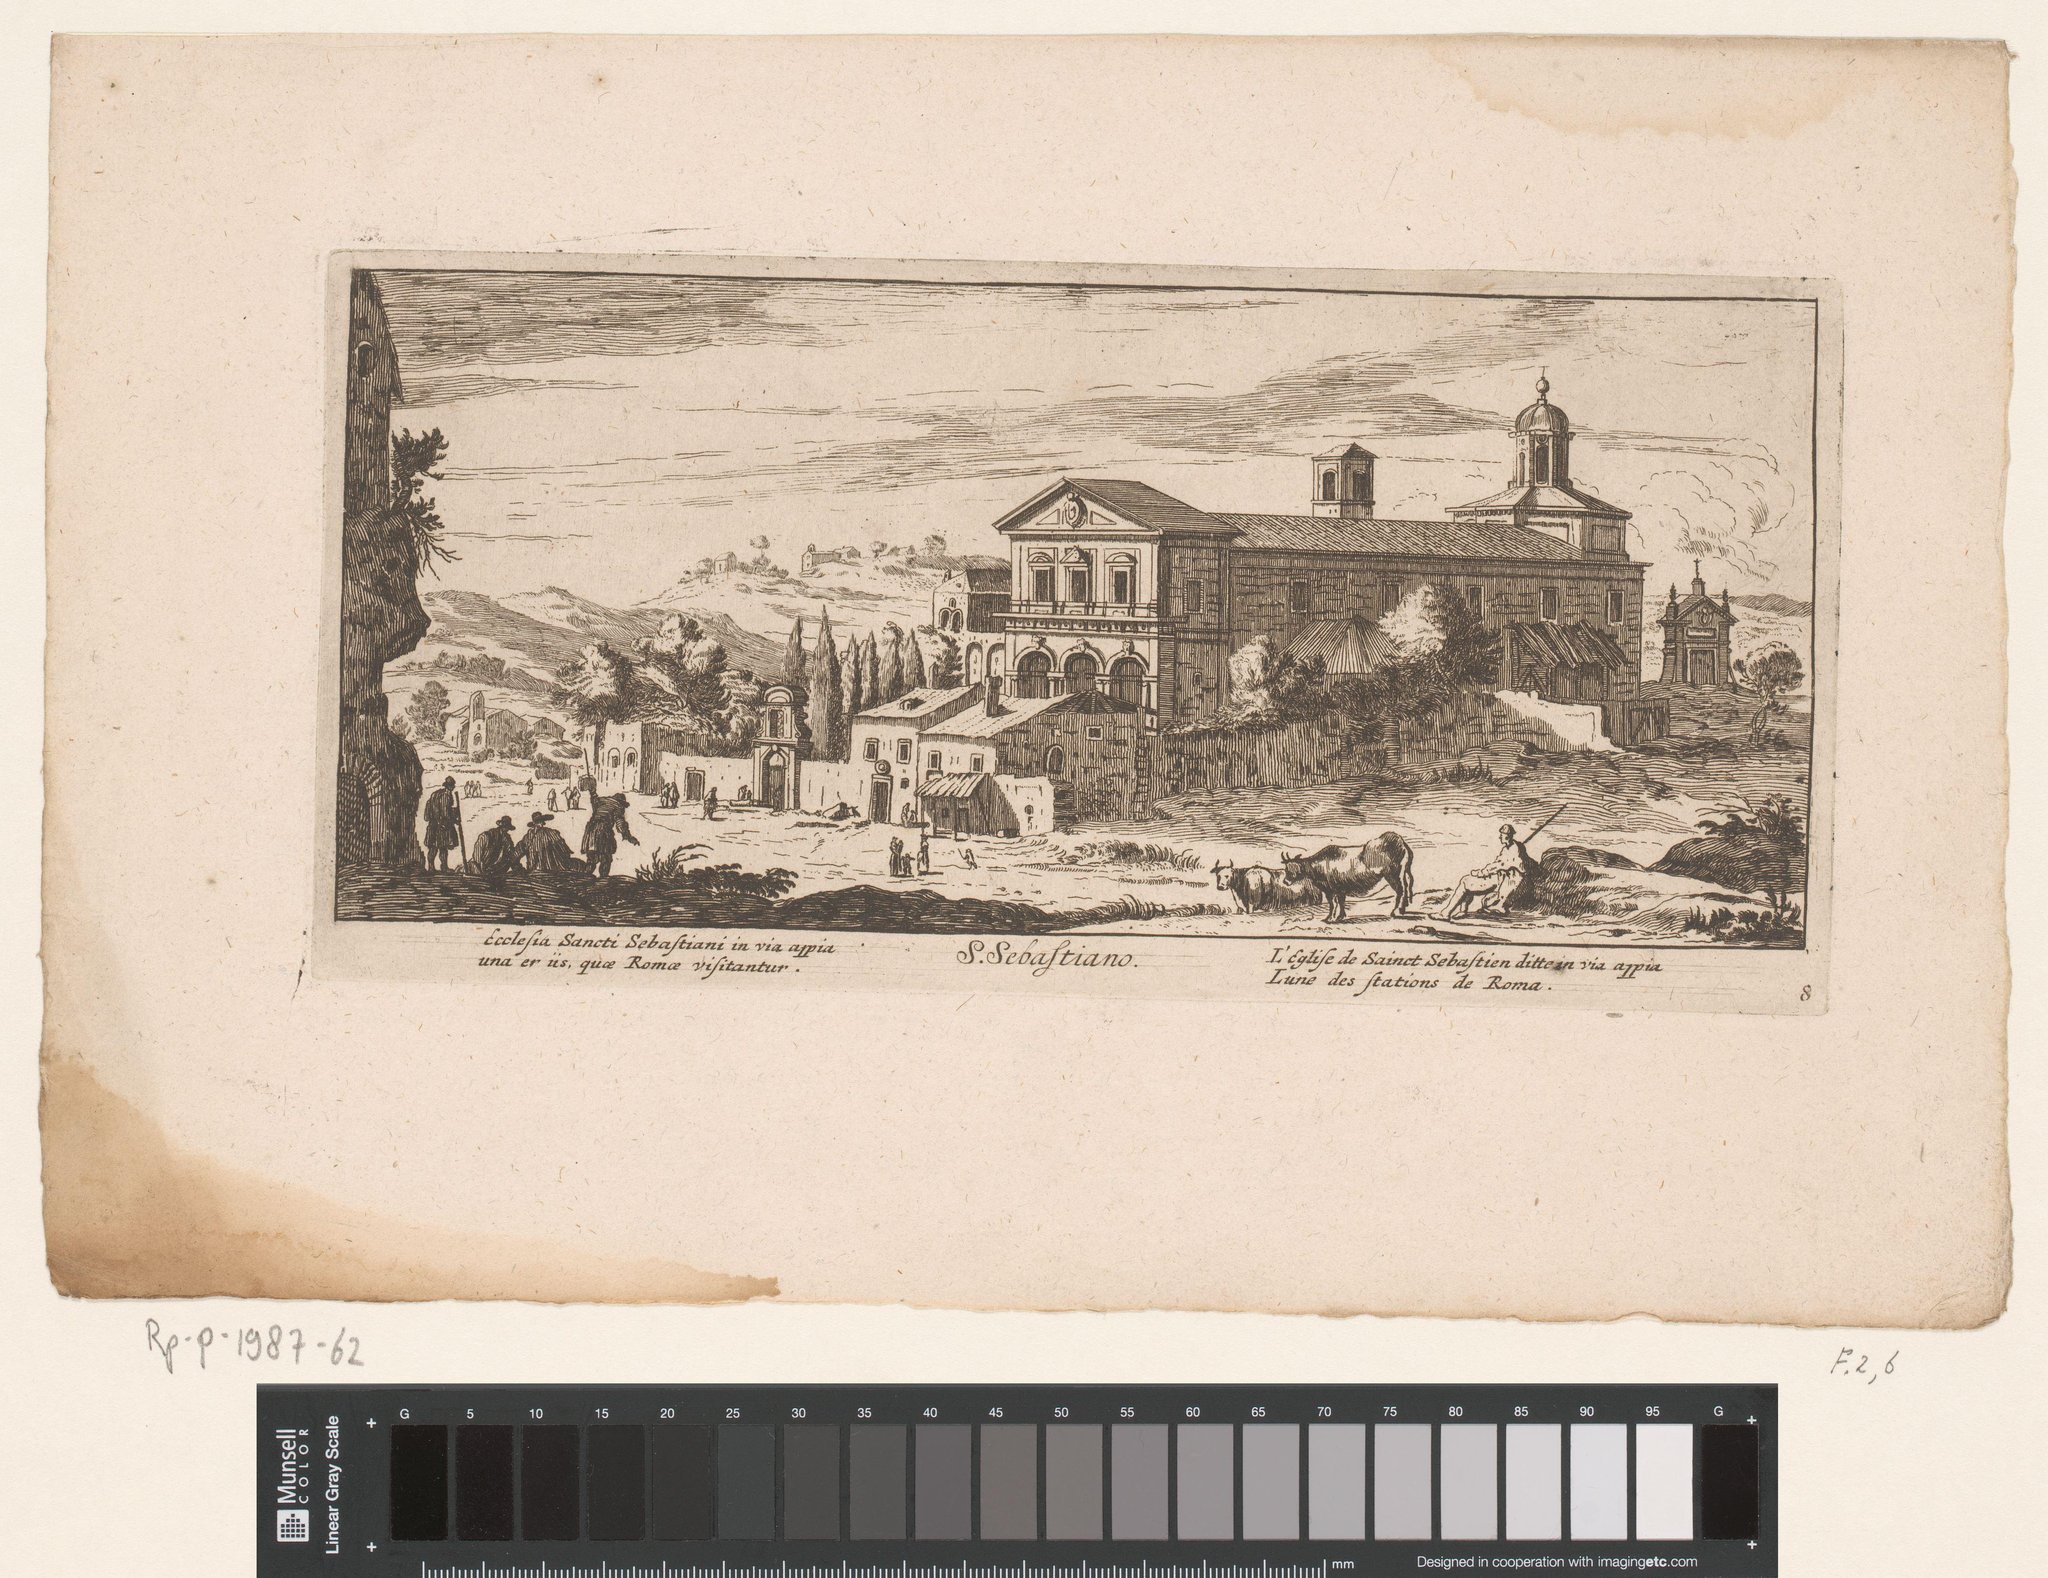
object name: print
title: Gezicht op de Sint-Sebastiaan buiten de Muren, te Rome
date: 1648-1712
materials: paper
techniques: etching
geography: amsterdam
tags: church (exterior)